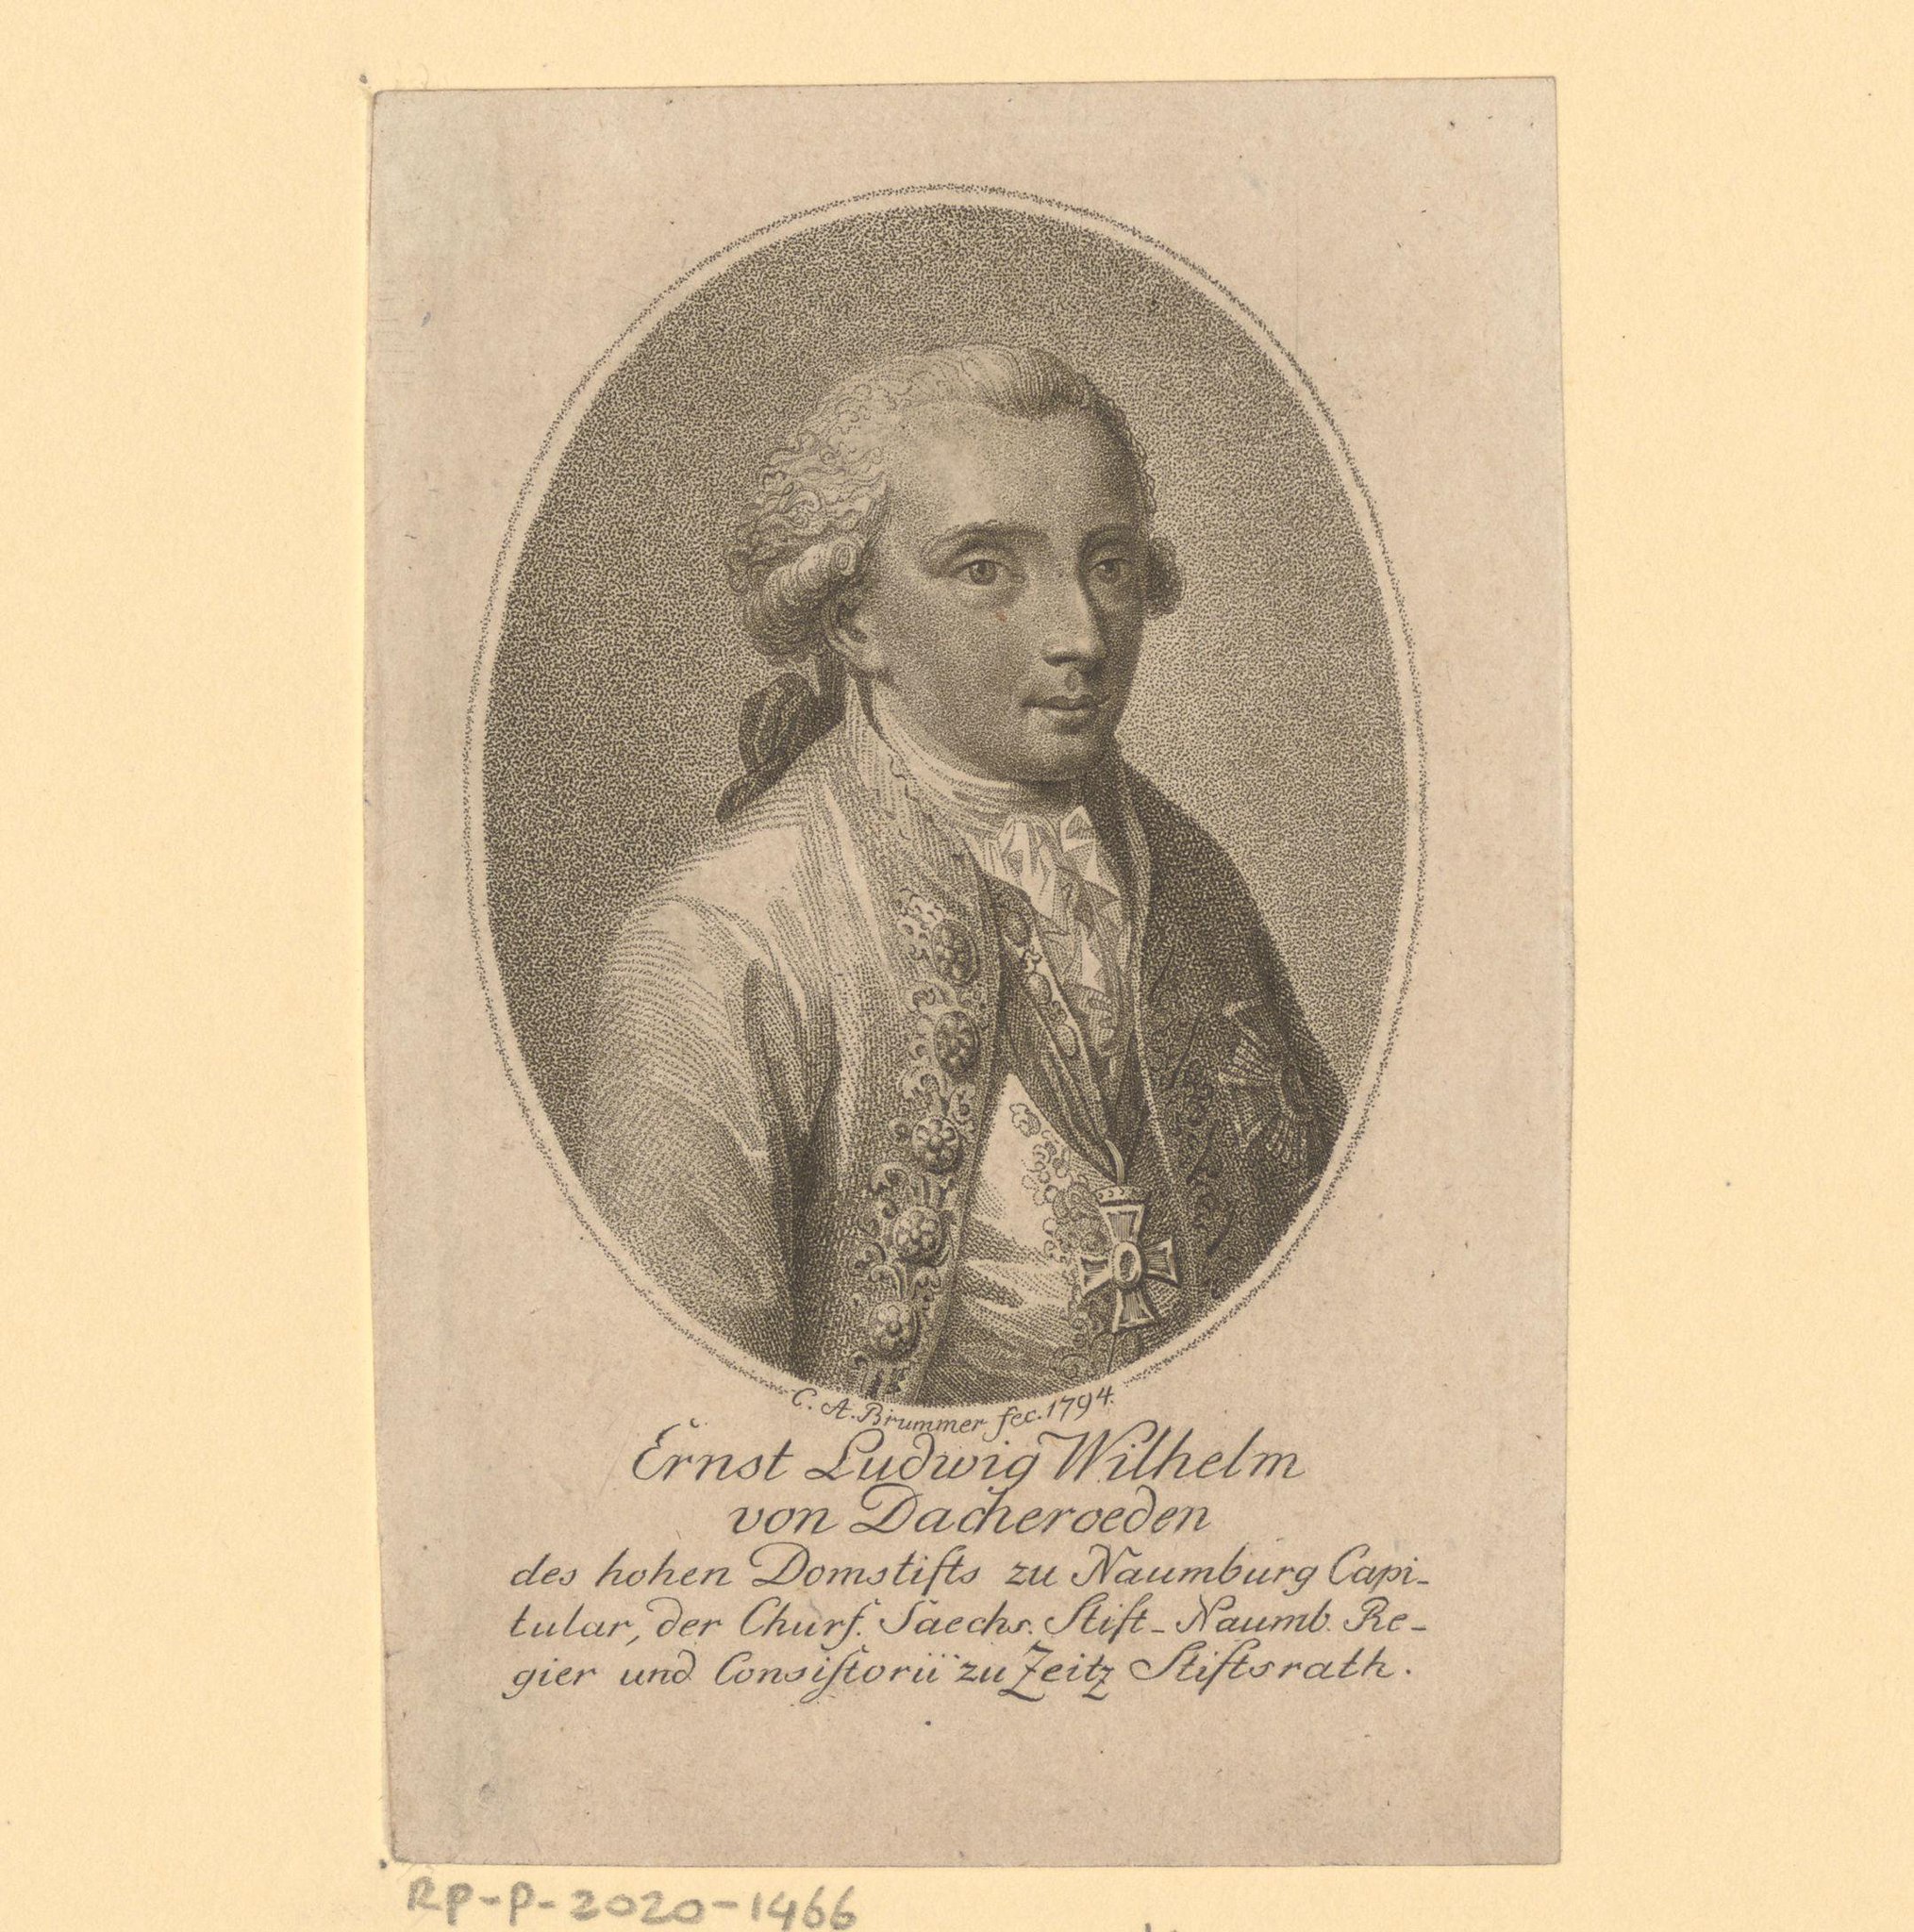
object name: print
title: Ernst Ludwig Wilhelm von Dacheroeden des hohen domstifts zu Naumburg (...)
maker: karl august brummer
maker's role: print maker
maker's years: 1769-1803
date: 1794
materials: paper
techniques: etching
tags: official; civil servant; functionary (in general), historical persons